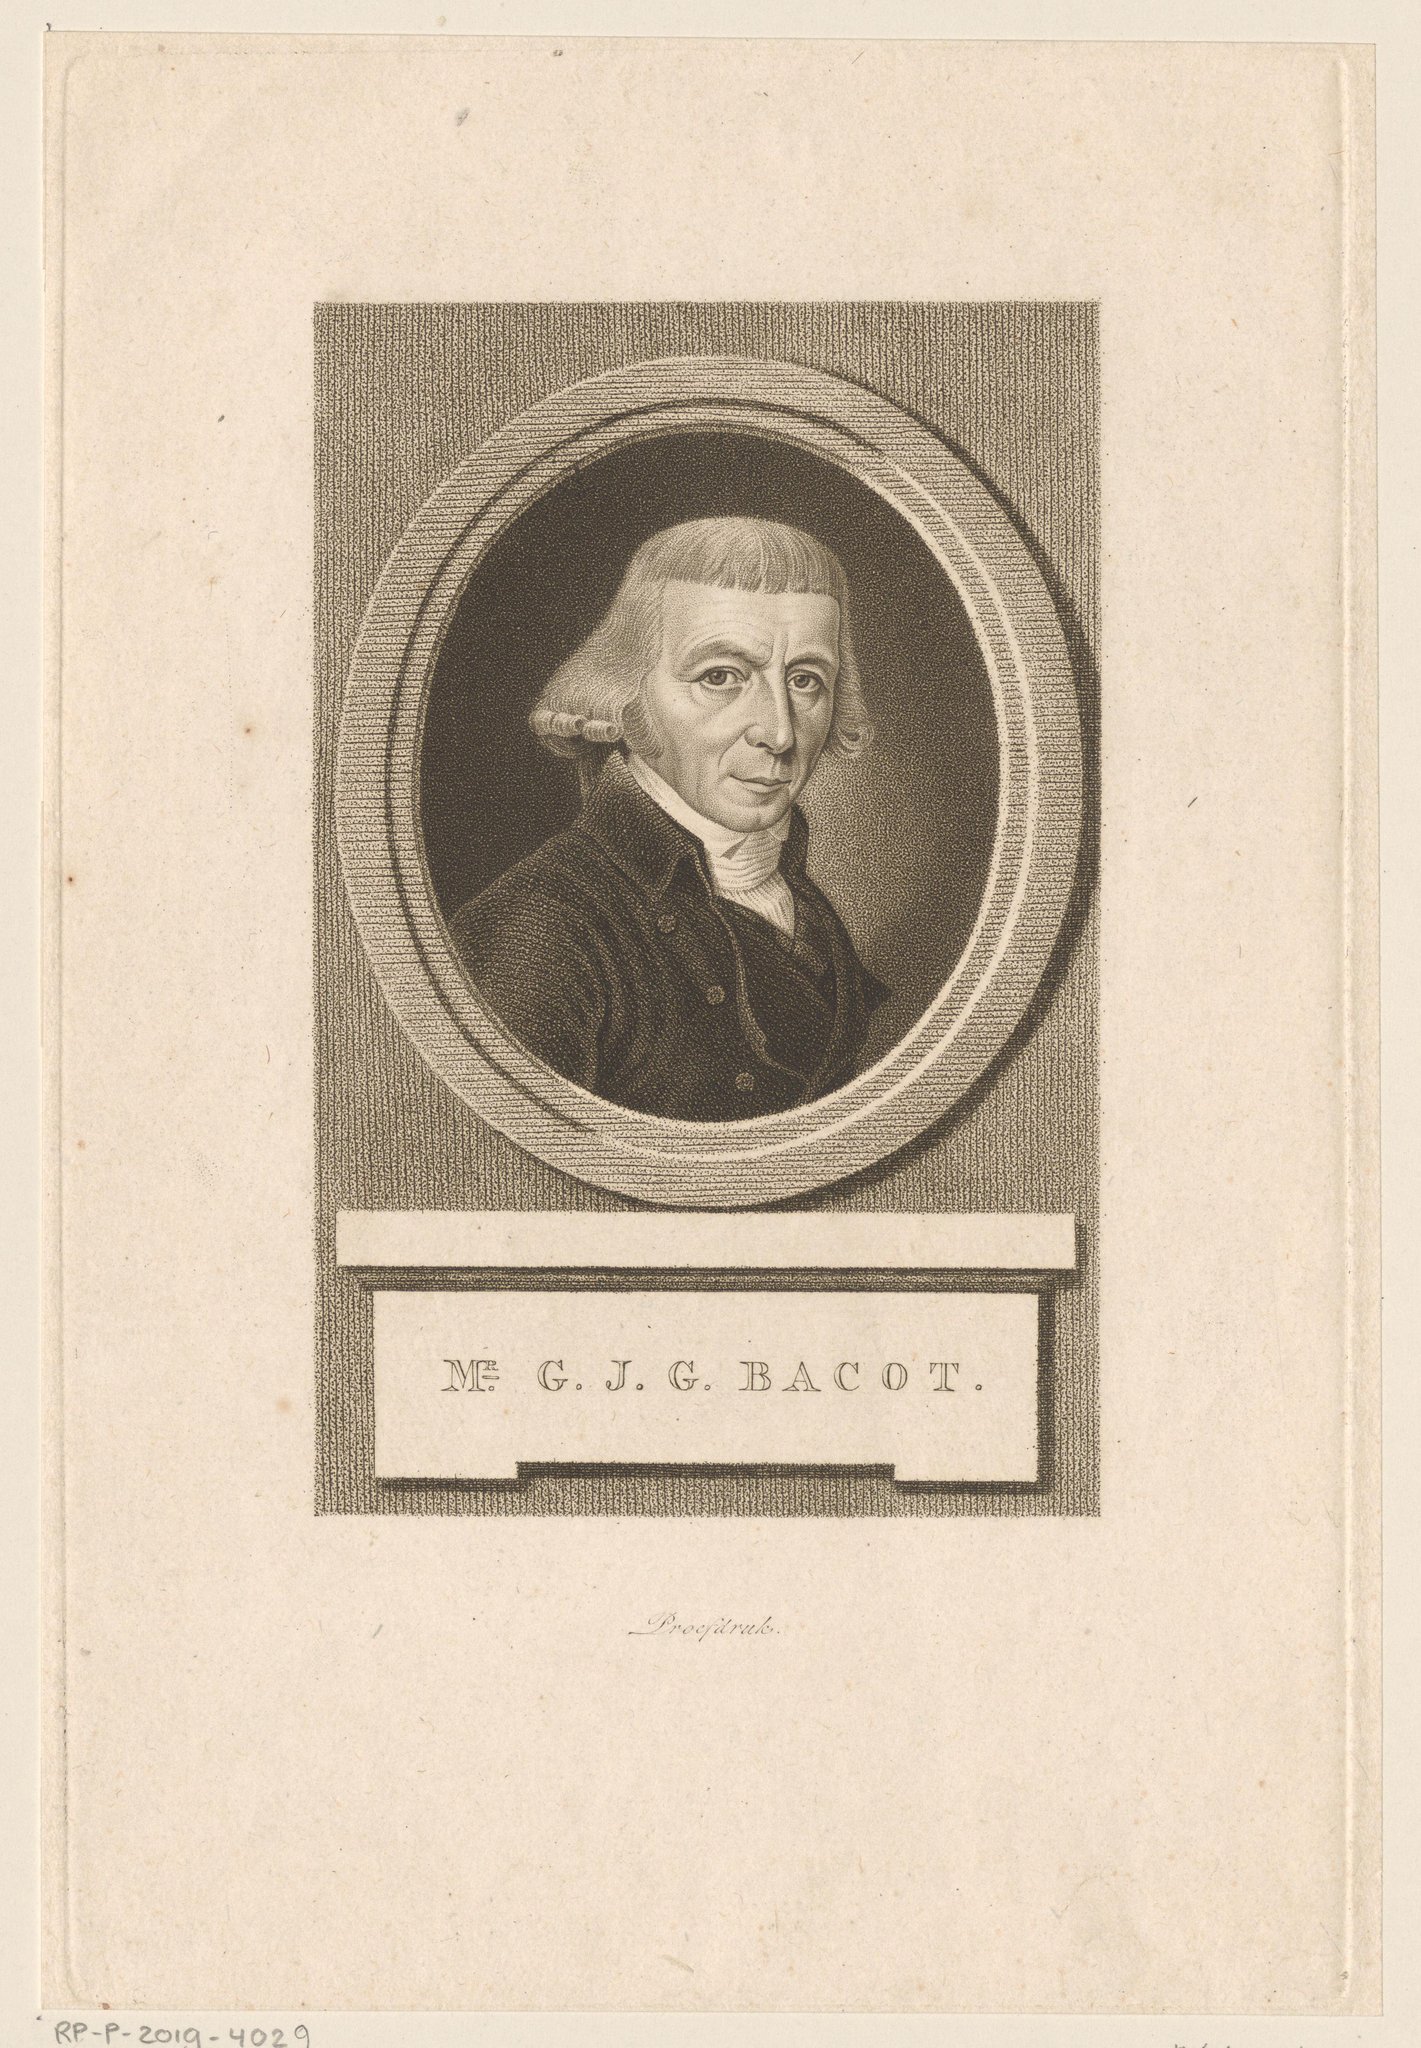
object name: print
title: Portret van Gerard Jacob Georg Bacot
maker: Anonymous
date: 1780-1830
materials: paper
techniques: etching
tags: the hague, historical persons